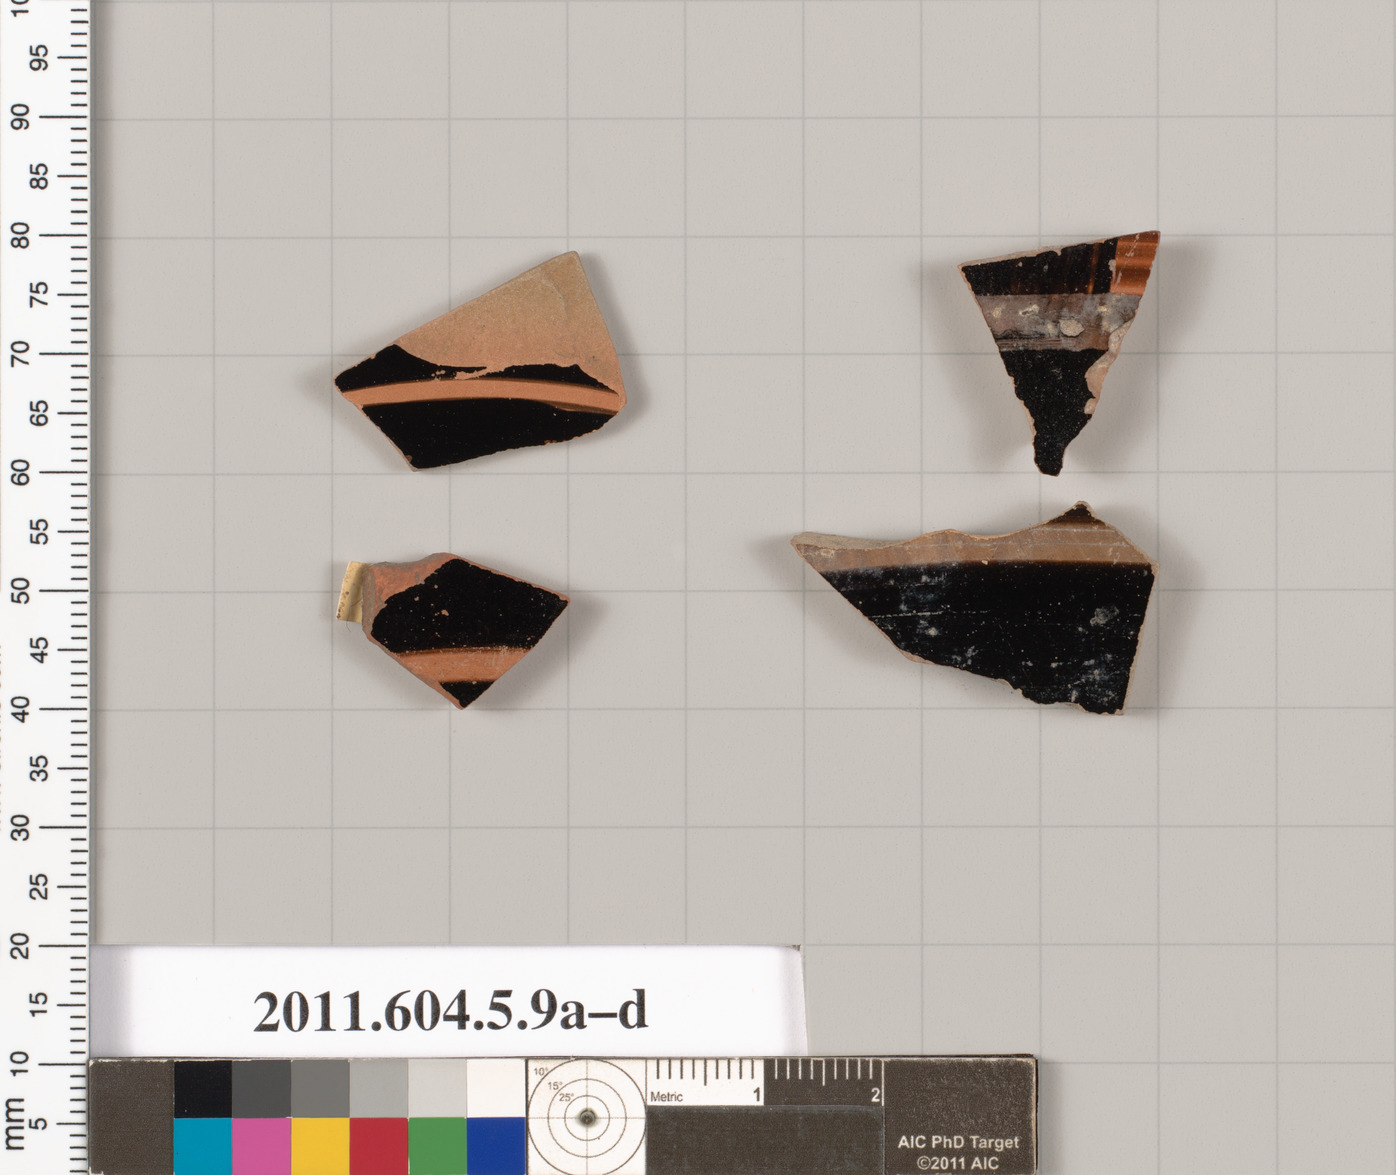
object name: kylix fragment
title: Terracotta fragments of kylikes (drinking cups)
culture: greek, attic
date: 475-451 BCE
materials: terracotta